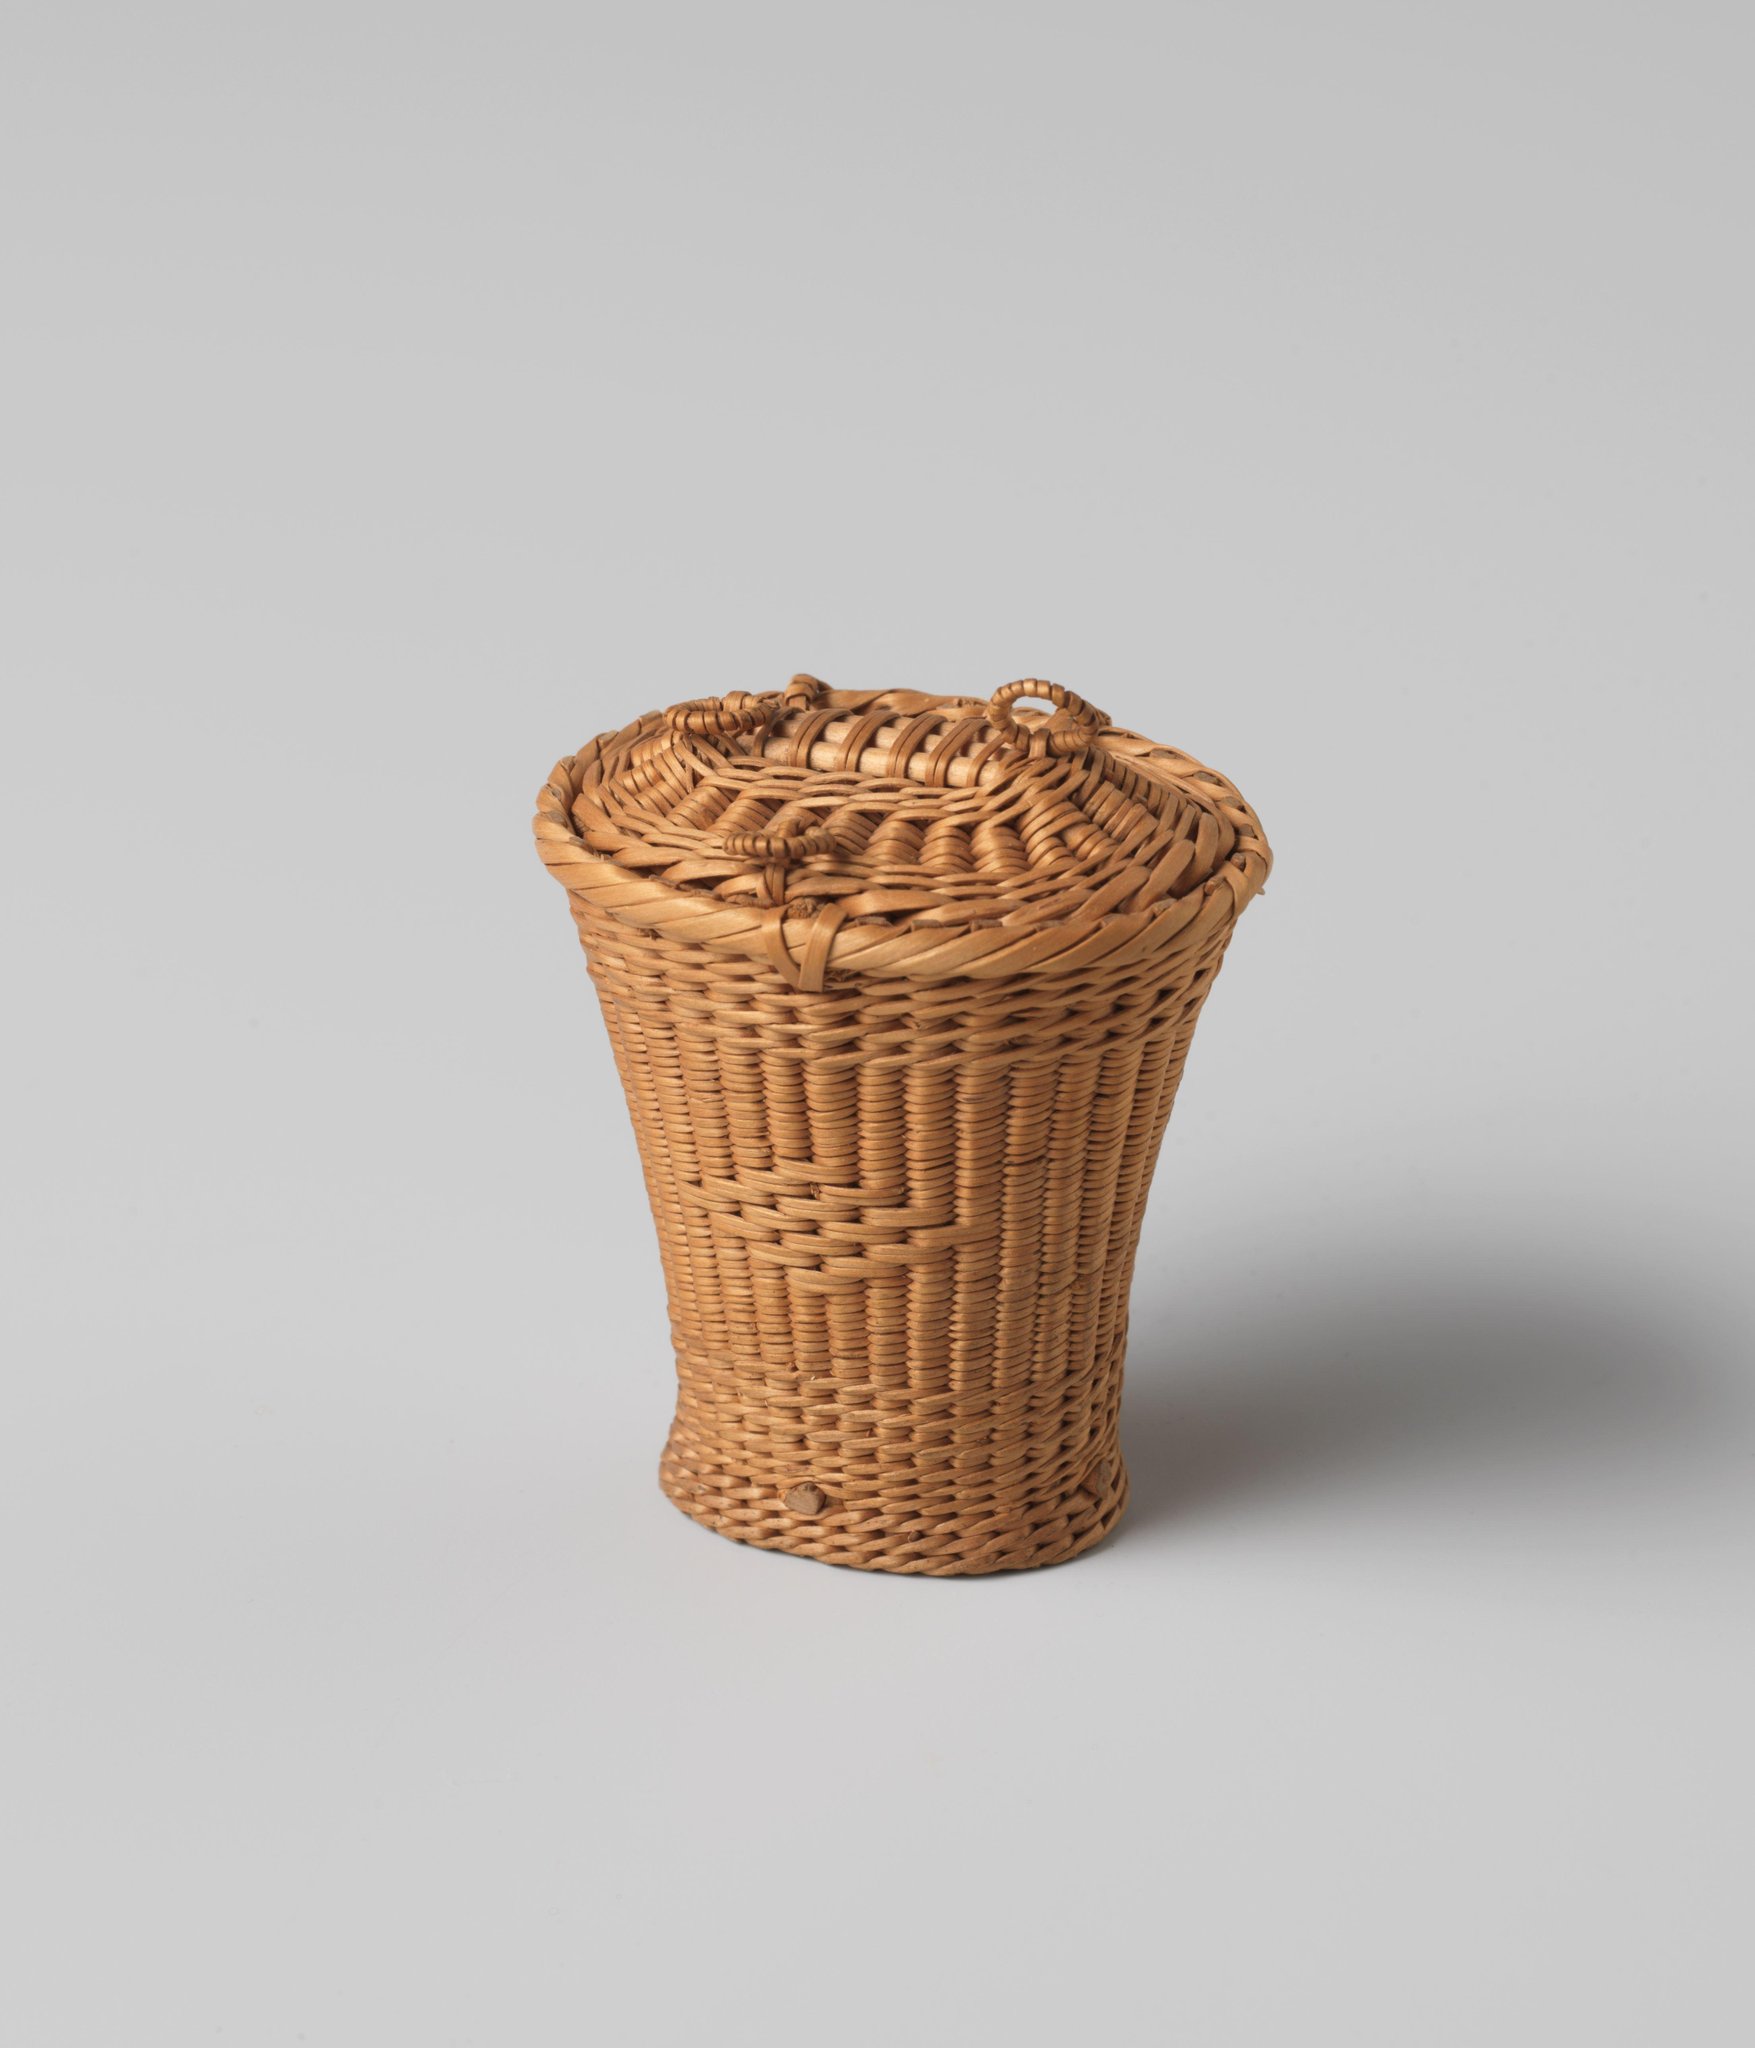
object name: hamper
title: Sluitmand, ovaal, gevlochten met ruitmotief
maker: Anonymous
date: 1675-1700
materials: plant material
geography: halle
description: Hoge ovale dichte mand van gespleten wilgenteen, deksel aan scharnieren met drie ringen; gevlochten met ruitmotief aan voor- en achterzijde.